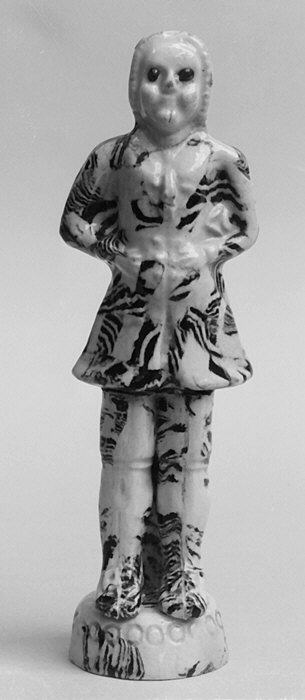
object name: figure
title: Man holding flowers (?)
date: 1745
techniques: salt glaze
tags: men